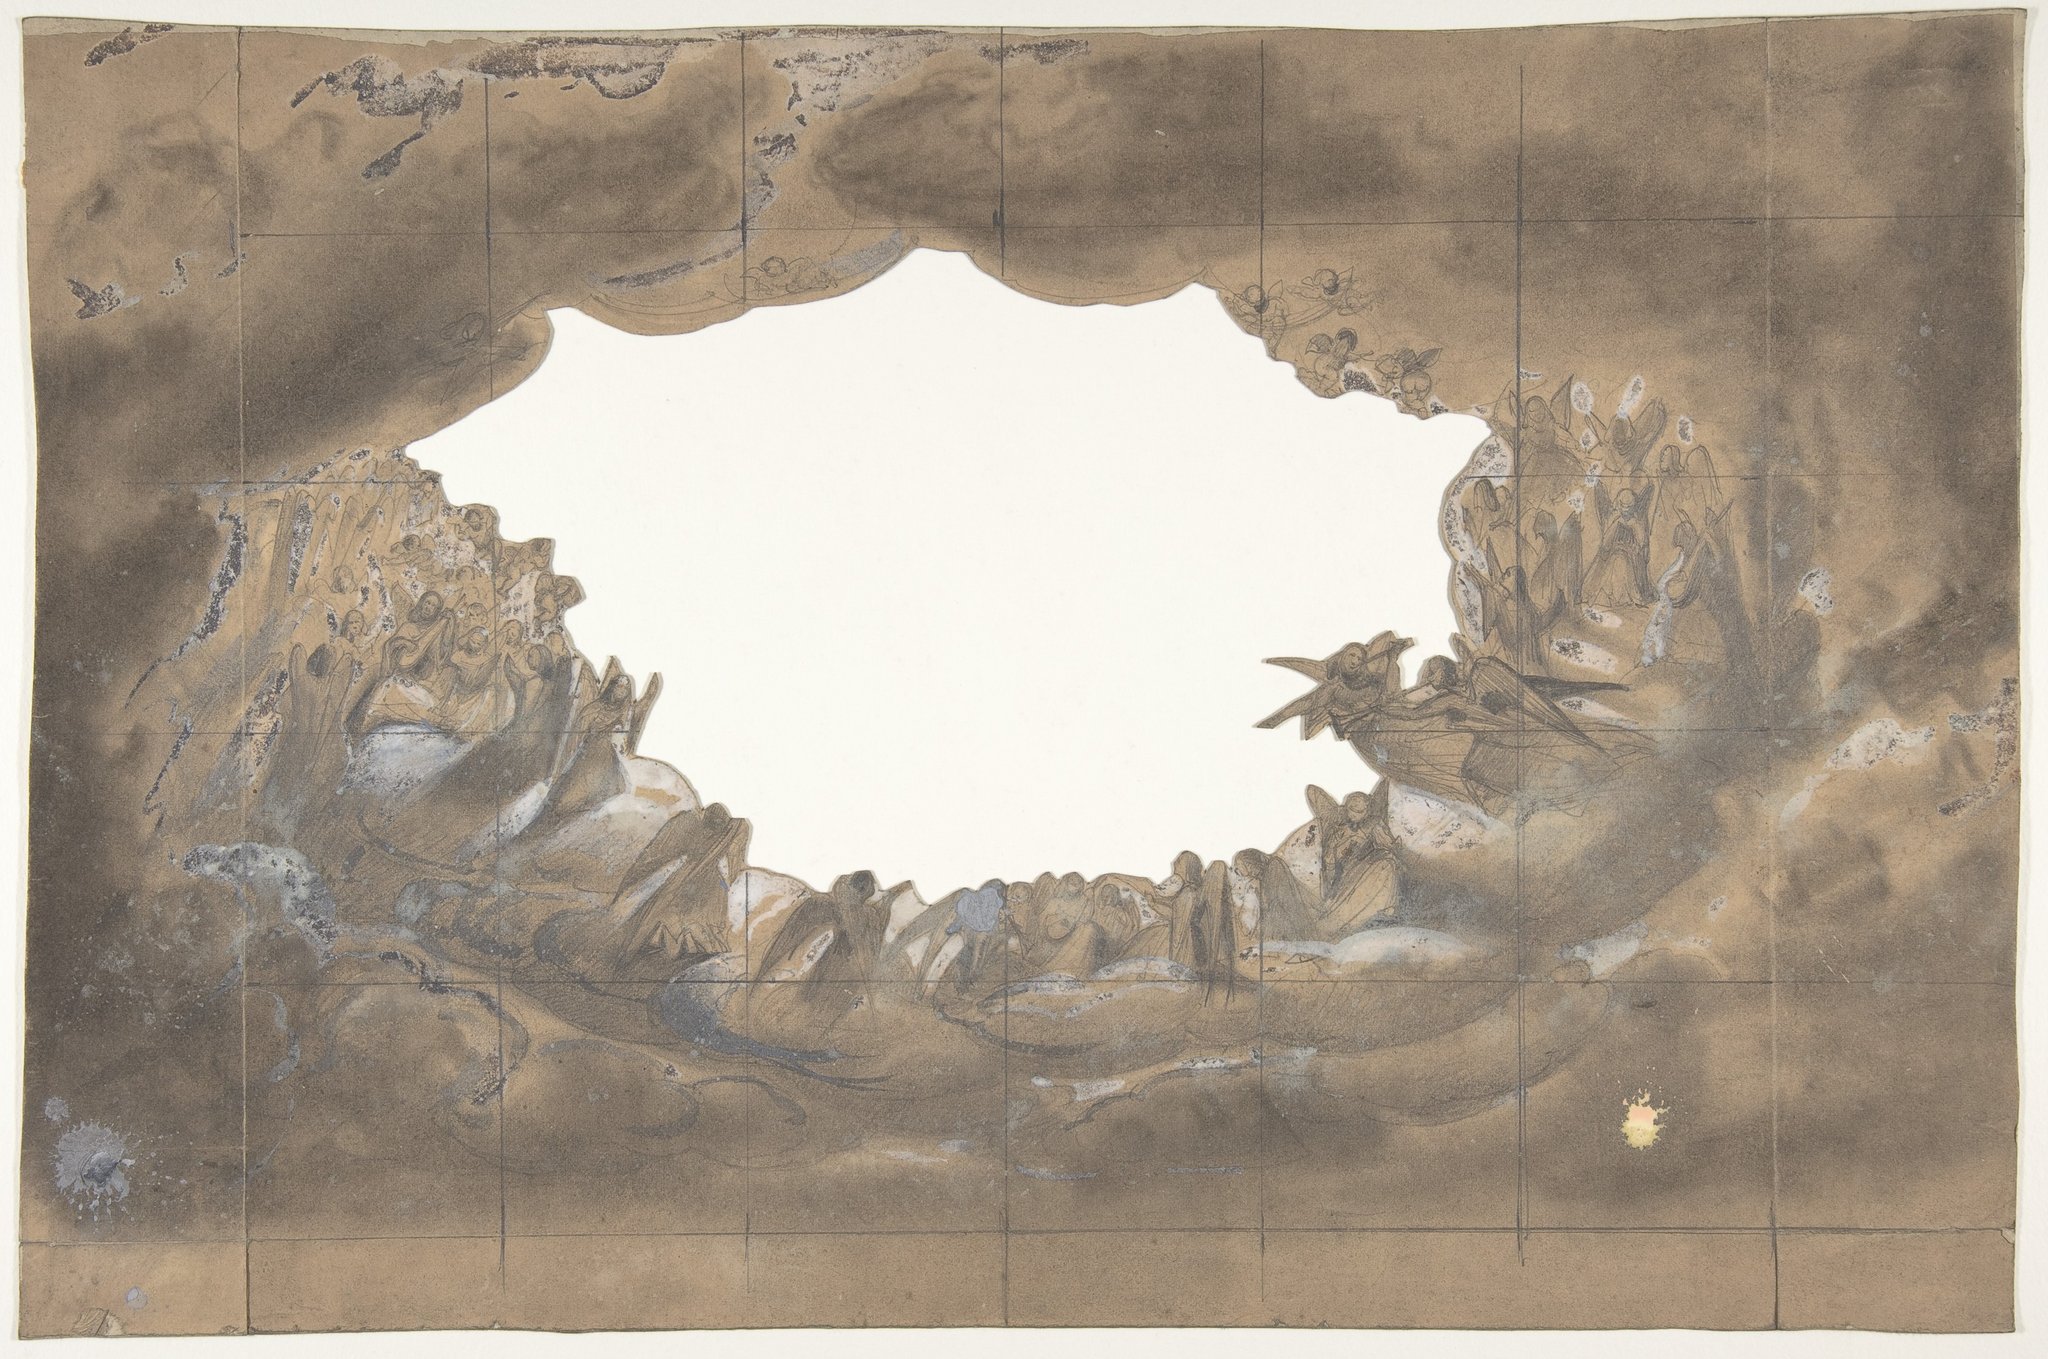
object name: drawing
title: Design for a Stage Set at the Opéra, Paris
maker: eugène cicéri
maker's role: artist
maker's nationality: french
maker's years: 1813-1890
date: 1828-1890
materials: chalk, graphite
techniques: heightening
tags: stage design